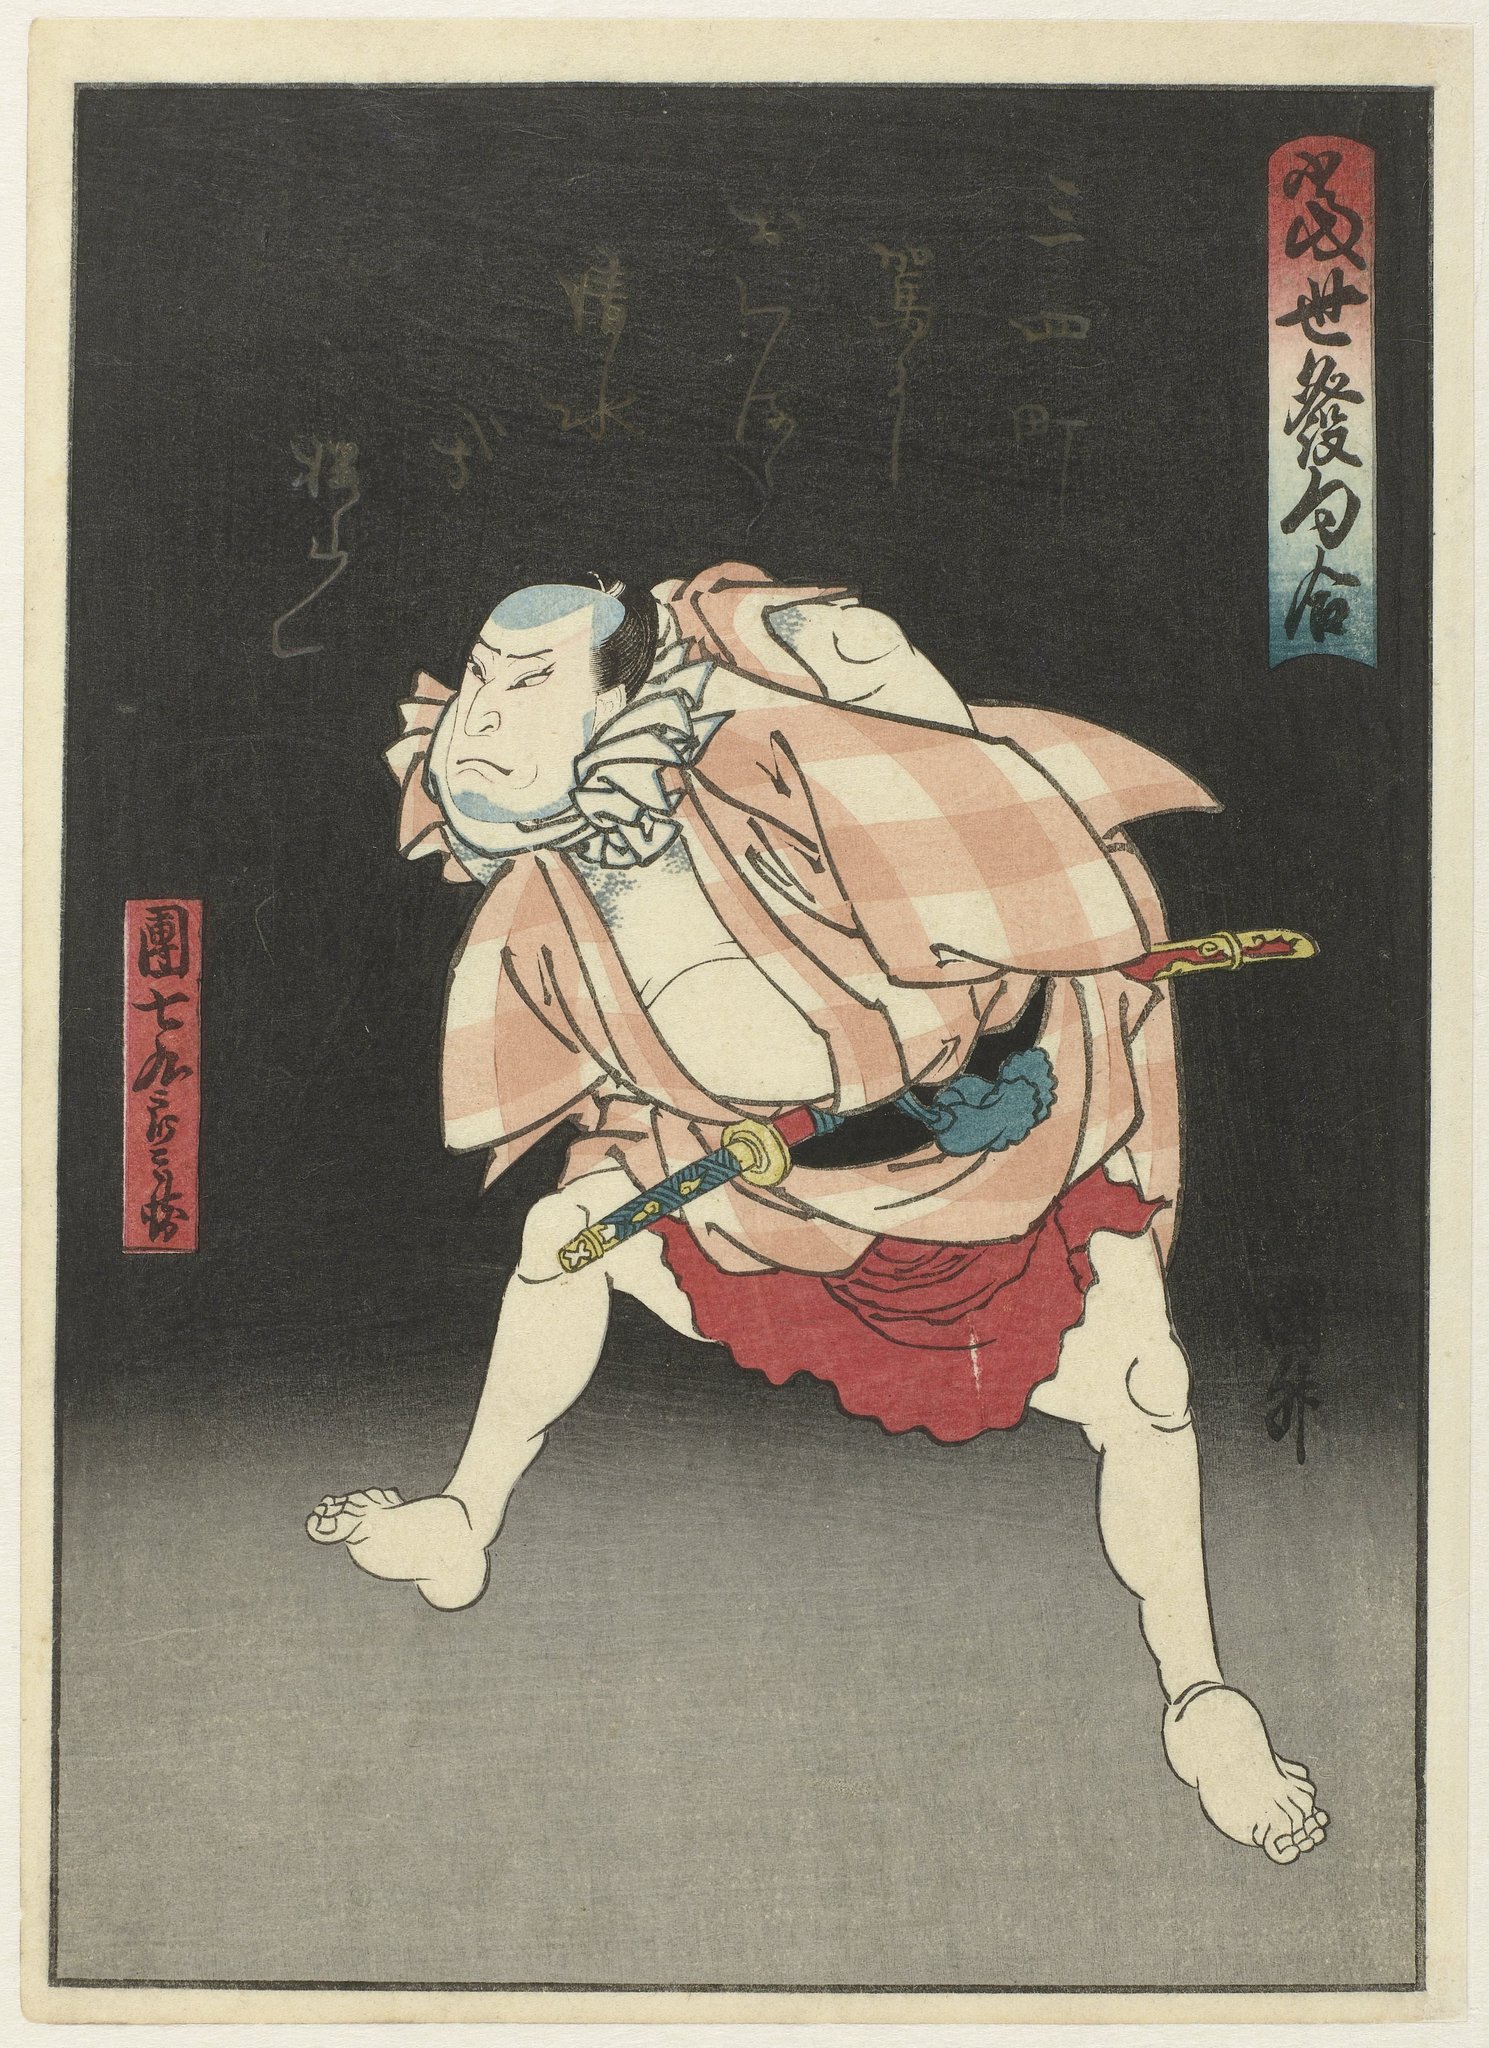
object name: print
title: Tôsei hokku awase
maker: utagawa kunimasu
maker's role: print maker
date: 1850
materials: paper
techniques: woodcut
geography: osaka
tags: adult man, hacking and thrusting weapons: sword, actor (on the stage)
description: Toneelspeler Nakamura Utaemon IV in de rol van Danshichi Kurobei, in het stuk "Natsumatsuri Naniwa kagami", opgevoerd in het Naka Theater, in de vijfde maand van 1850.